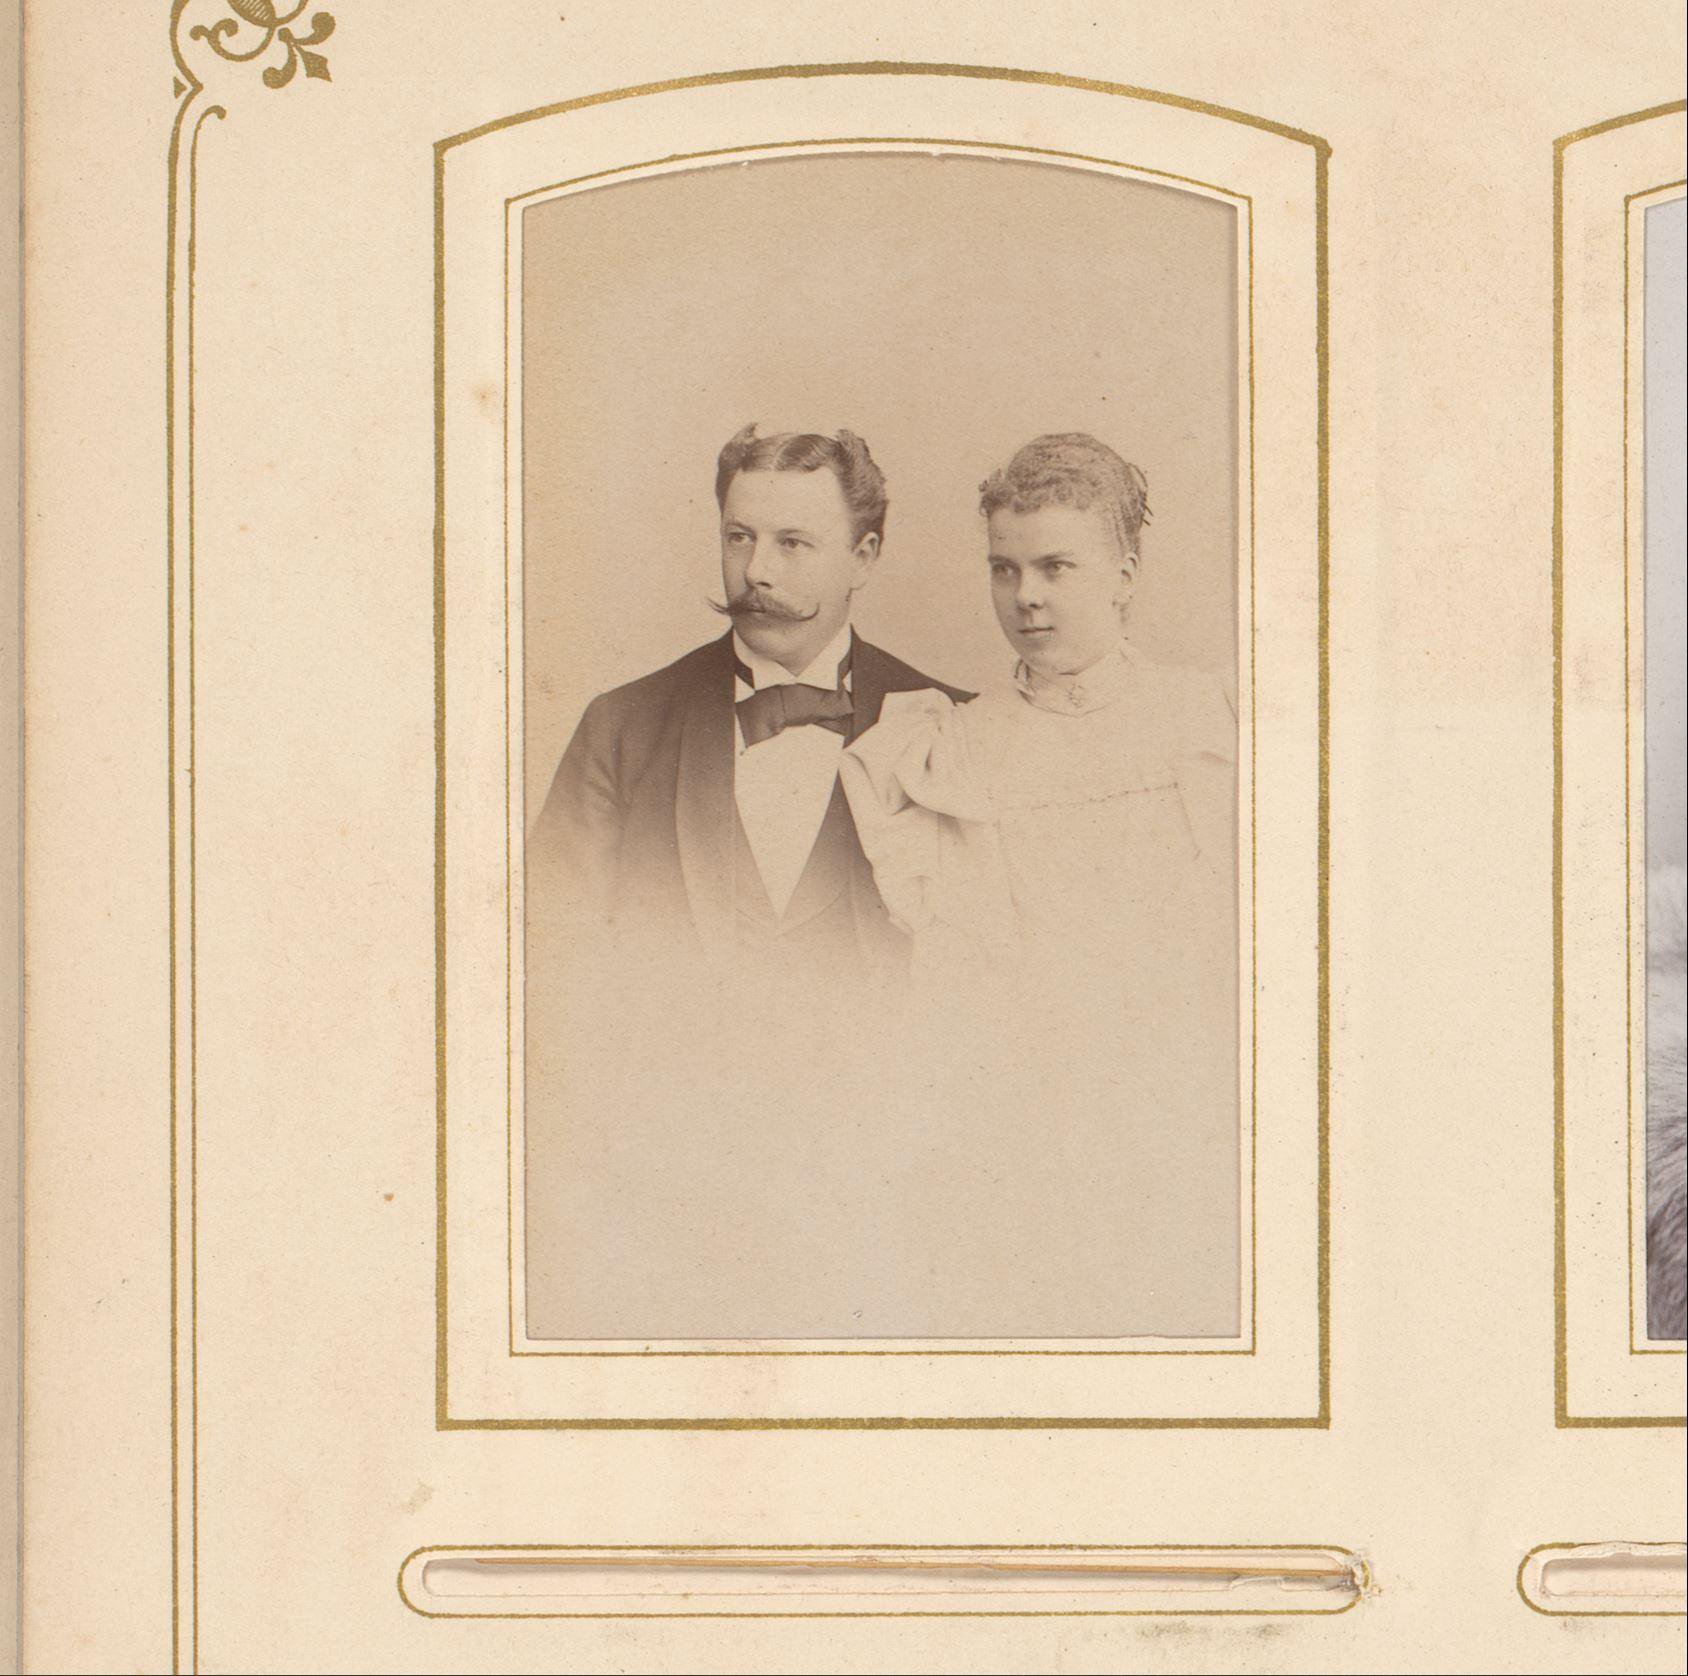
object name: carte de visite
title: Portret van een man en een vrouw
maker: jean baptiste feilner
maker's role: fotograaf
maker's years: 1844-1912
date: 1875-1899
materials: cardboard, photographic support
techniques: albumen print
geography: bremen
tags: historical persons - bb - woman, historical persons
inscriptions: inscription: ‘Jean Baptiste Feilner/ Hofphotograph Sr. Königl. Hoheit d. Erbgrofsherzogs v. Oldenburg/ HANNOVER/ Georgstr. 25./ BREMEN/ Richtweg 6b. Parterre./ OLDENBURG/ Rosenstr. 29./ BORKUM./ BRAUNSCHWEIG/ südliche Wilhelmstr. 88./ EMDEN.’